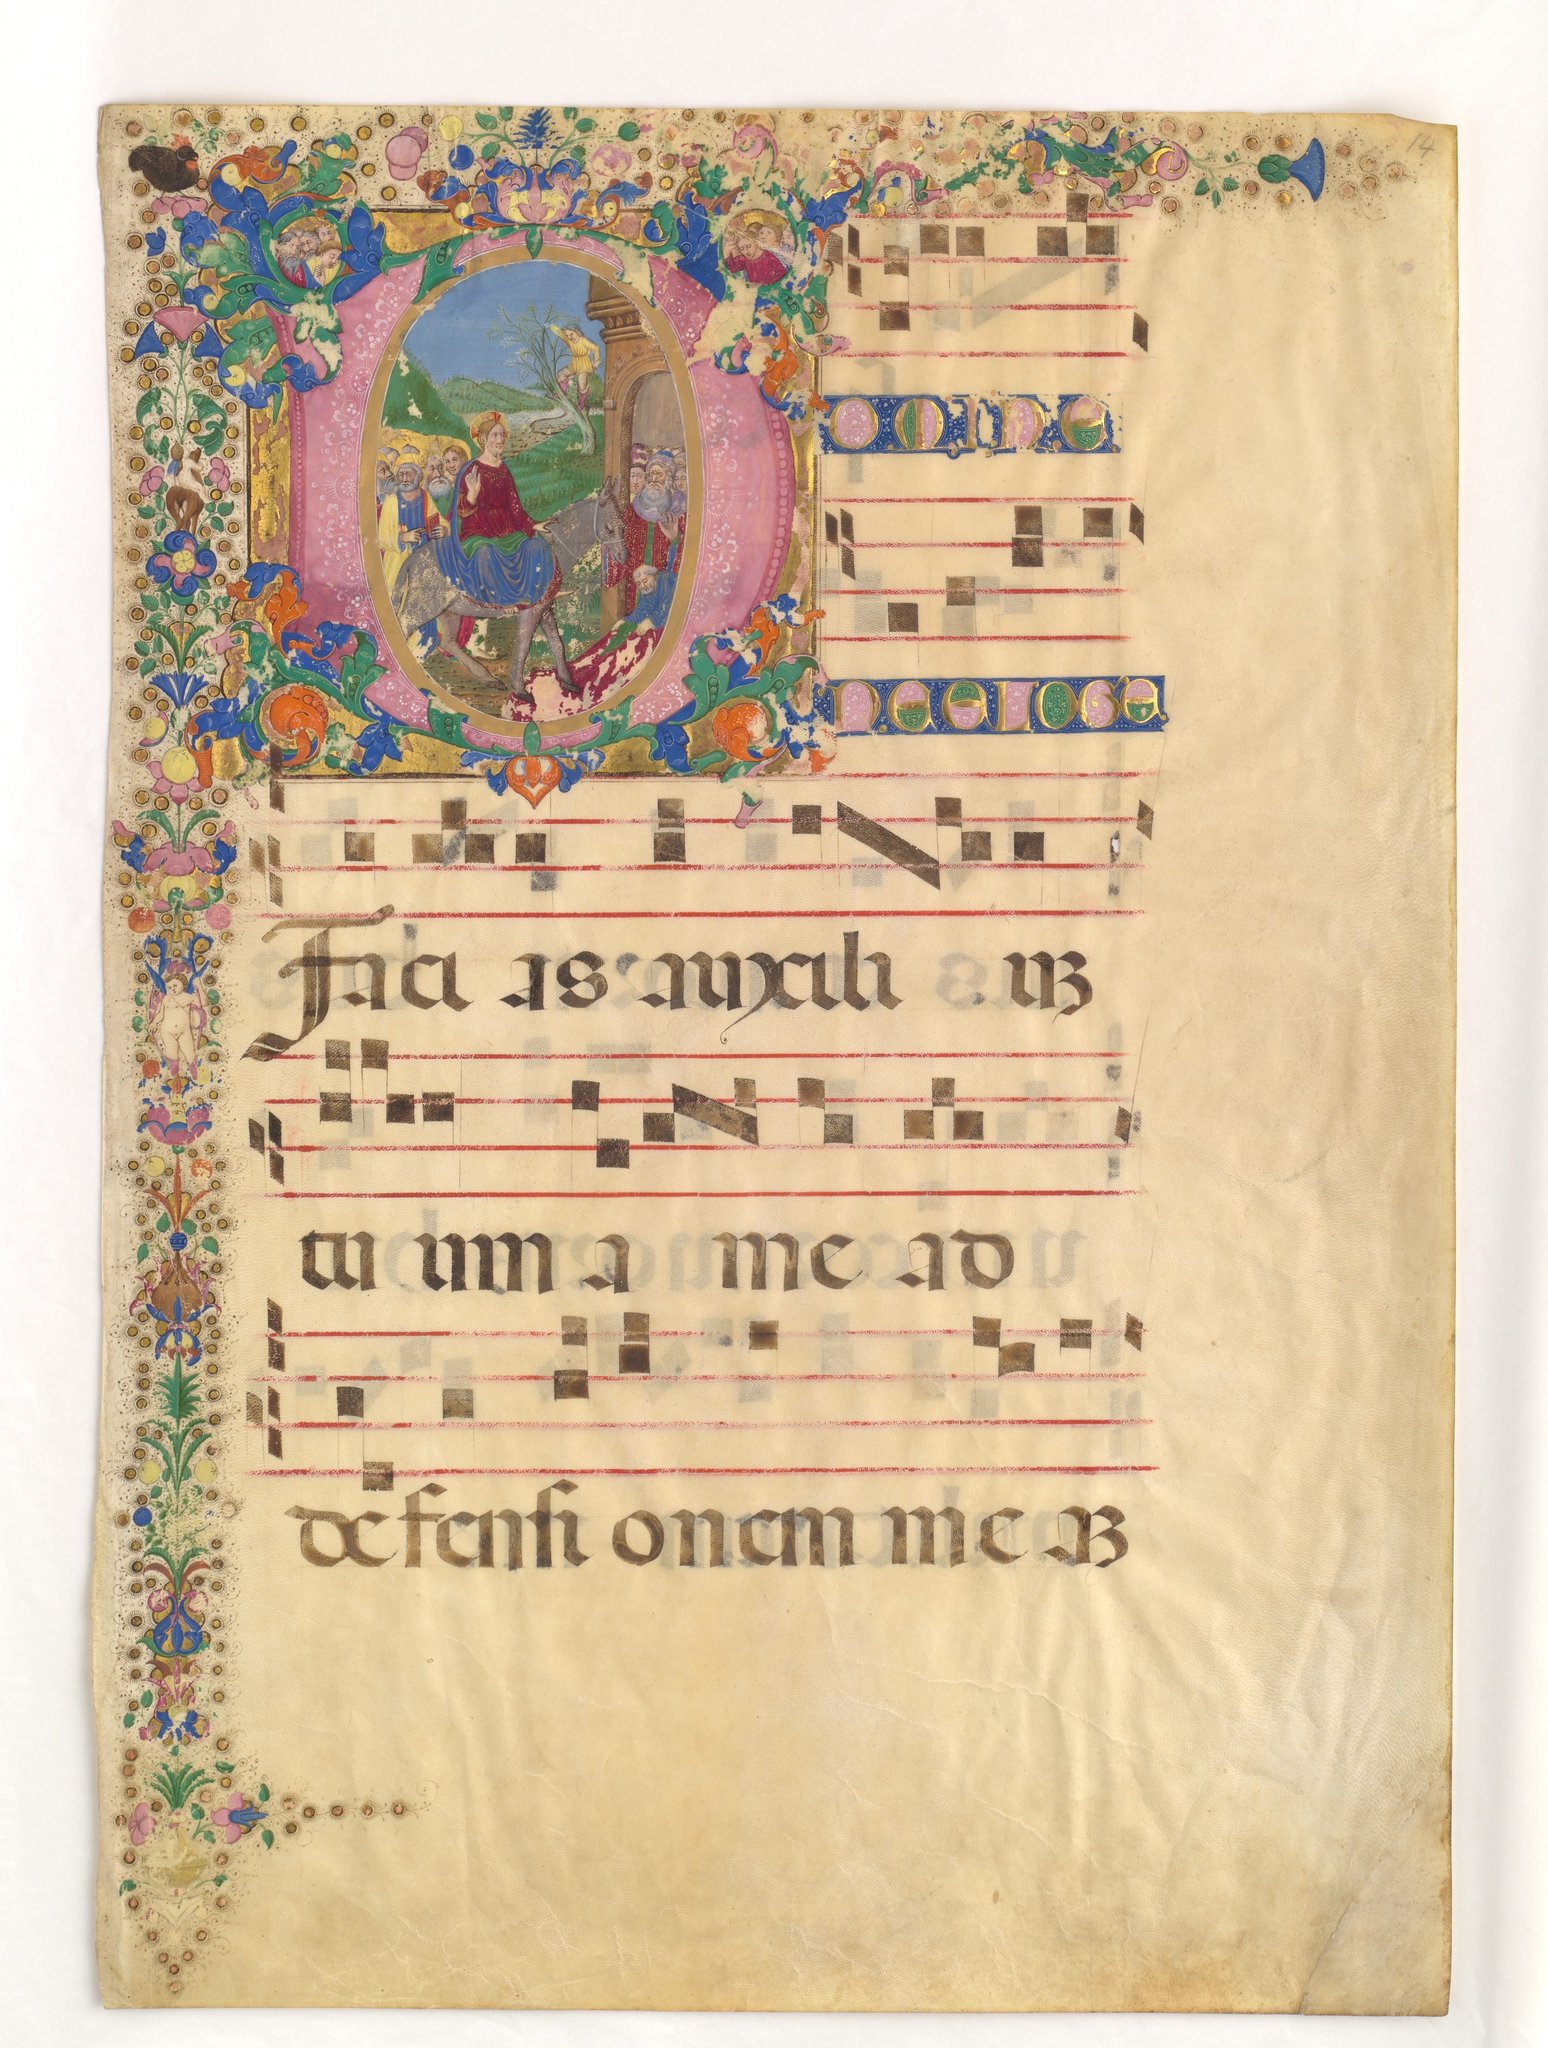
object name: choir book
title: Manuscript Leaf with Entry into Jerusalem on Palm Sunday in an Initial D, from a Gradual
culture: italian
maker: bartolomeo di domenico di guido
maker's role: artist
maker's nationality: italian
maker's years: 1430-1521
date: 1401-1600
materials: gold, ink, parchment, paint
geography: italy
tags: men,donkeys,angels,jesus